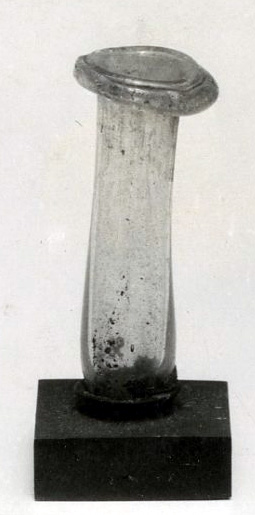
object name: bottle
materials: glass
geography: egypt